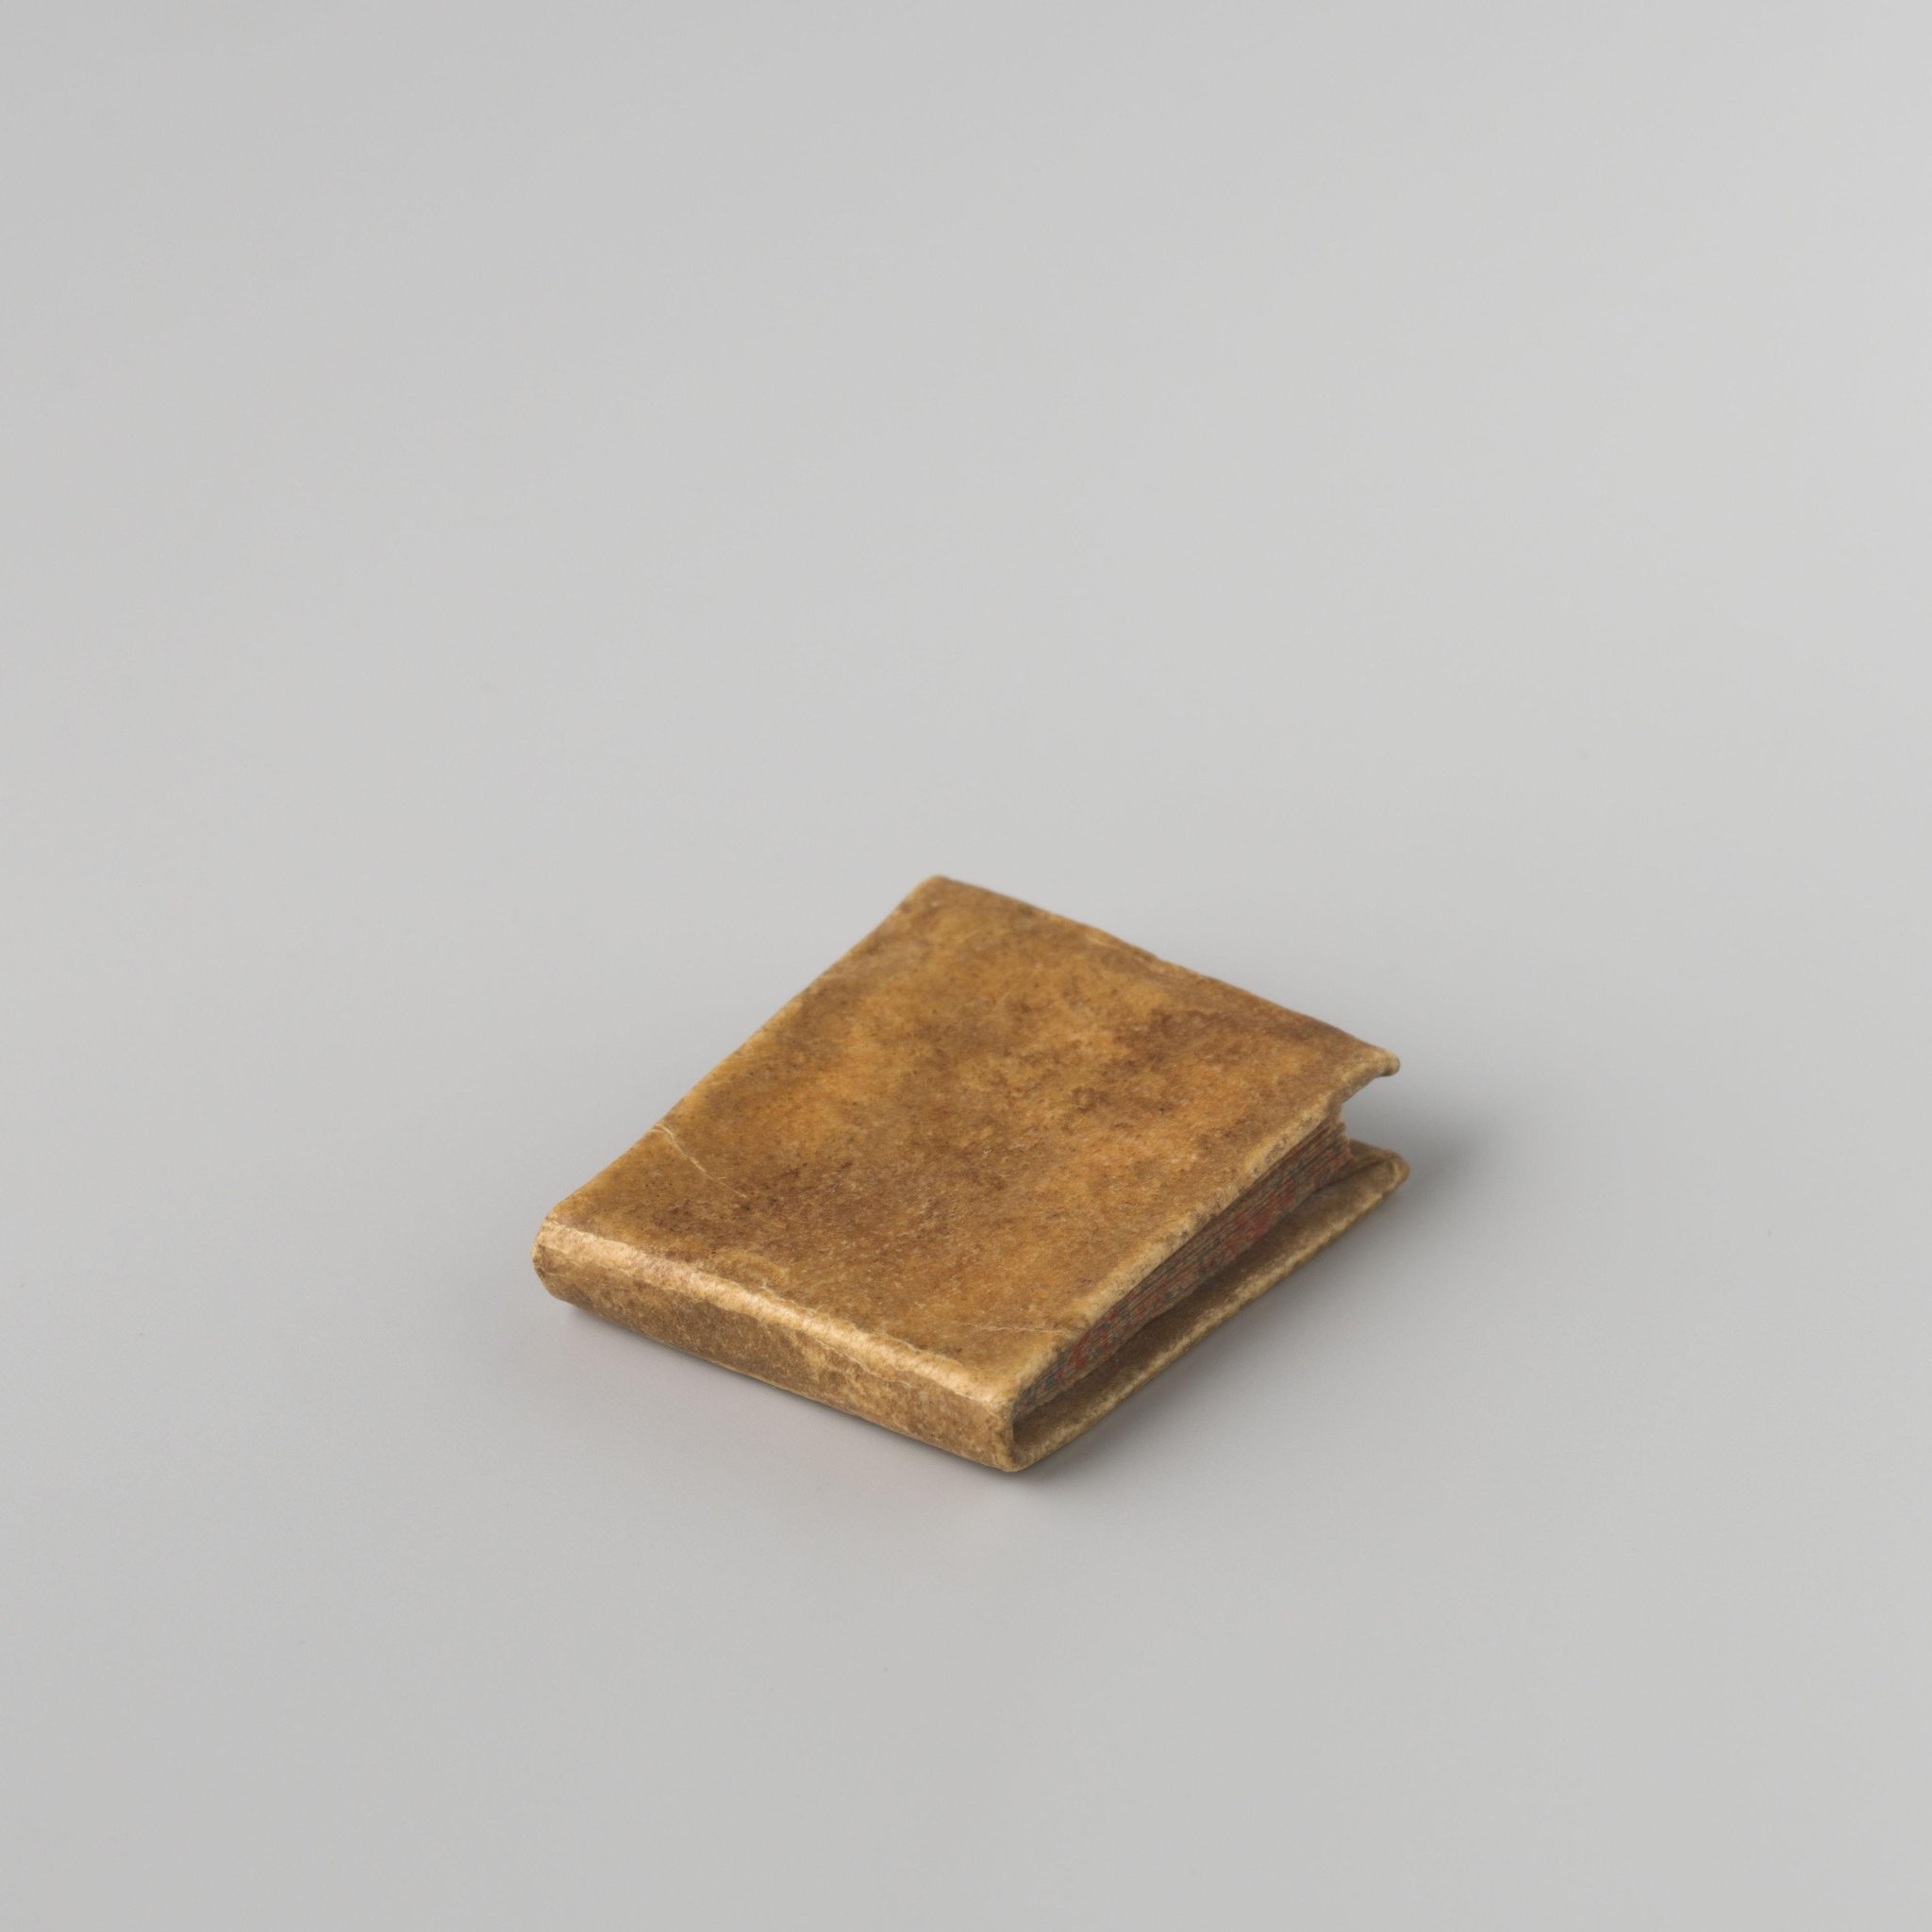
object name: miniature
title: Muziekboek voor hakkebord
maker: Anonymous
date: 1683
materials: paper, parchment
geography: amsterdam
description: Muziekboek, gebonden in donker gekleurd perkament, snede rood blauw gespat, blanco bladen, middelste katern van 8 bladen, 13 bladzijden beschreven met notebalken en noten van muziek; titelpagina: "Musijck opt' Hackbort", muziek "Rondeau" (2 stukjes).